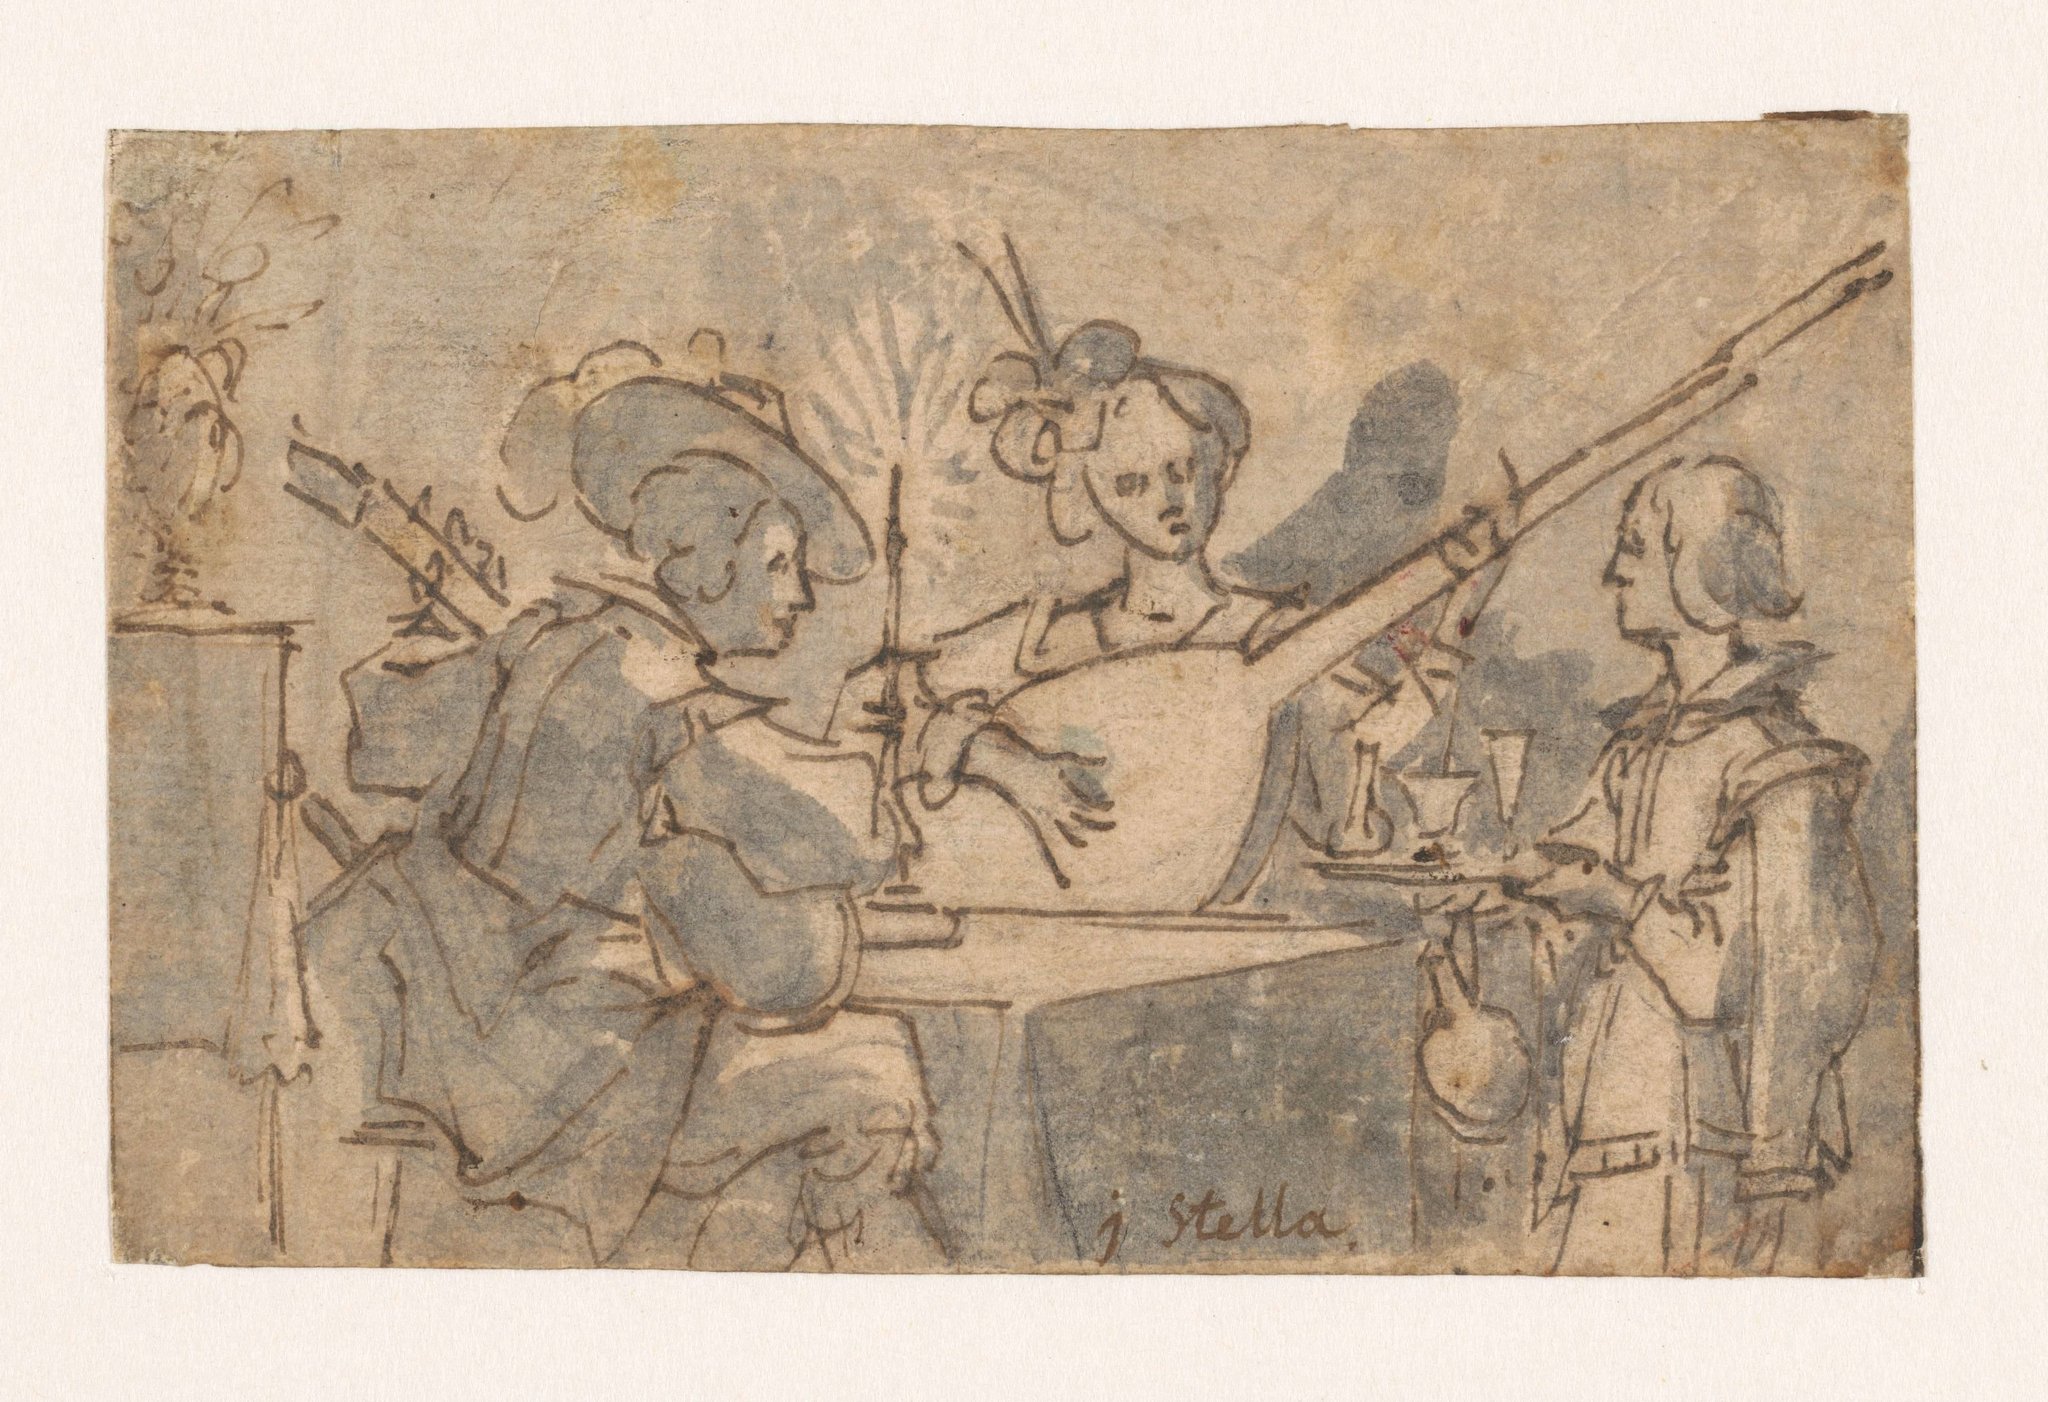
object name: drawing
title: Musicerend gezelschap bij kaarslicht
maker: jacques stella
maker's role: draughtsman, print maker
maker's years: 1596-1657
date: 1606-1657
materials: ink, paper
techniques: brush, pen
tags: small group of musicians, chamber orchestra, jazz band